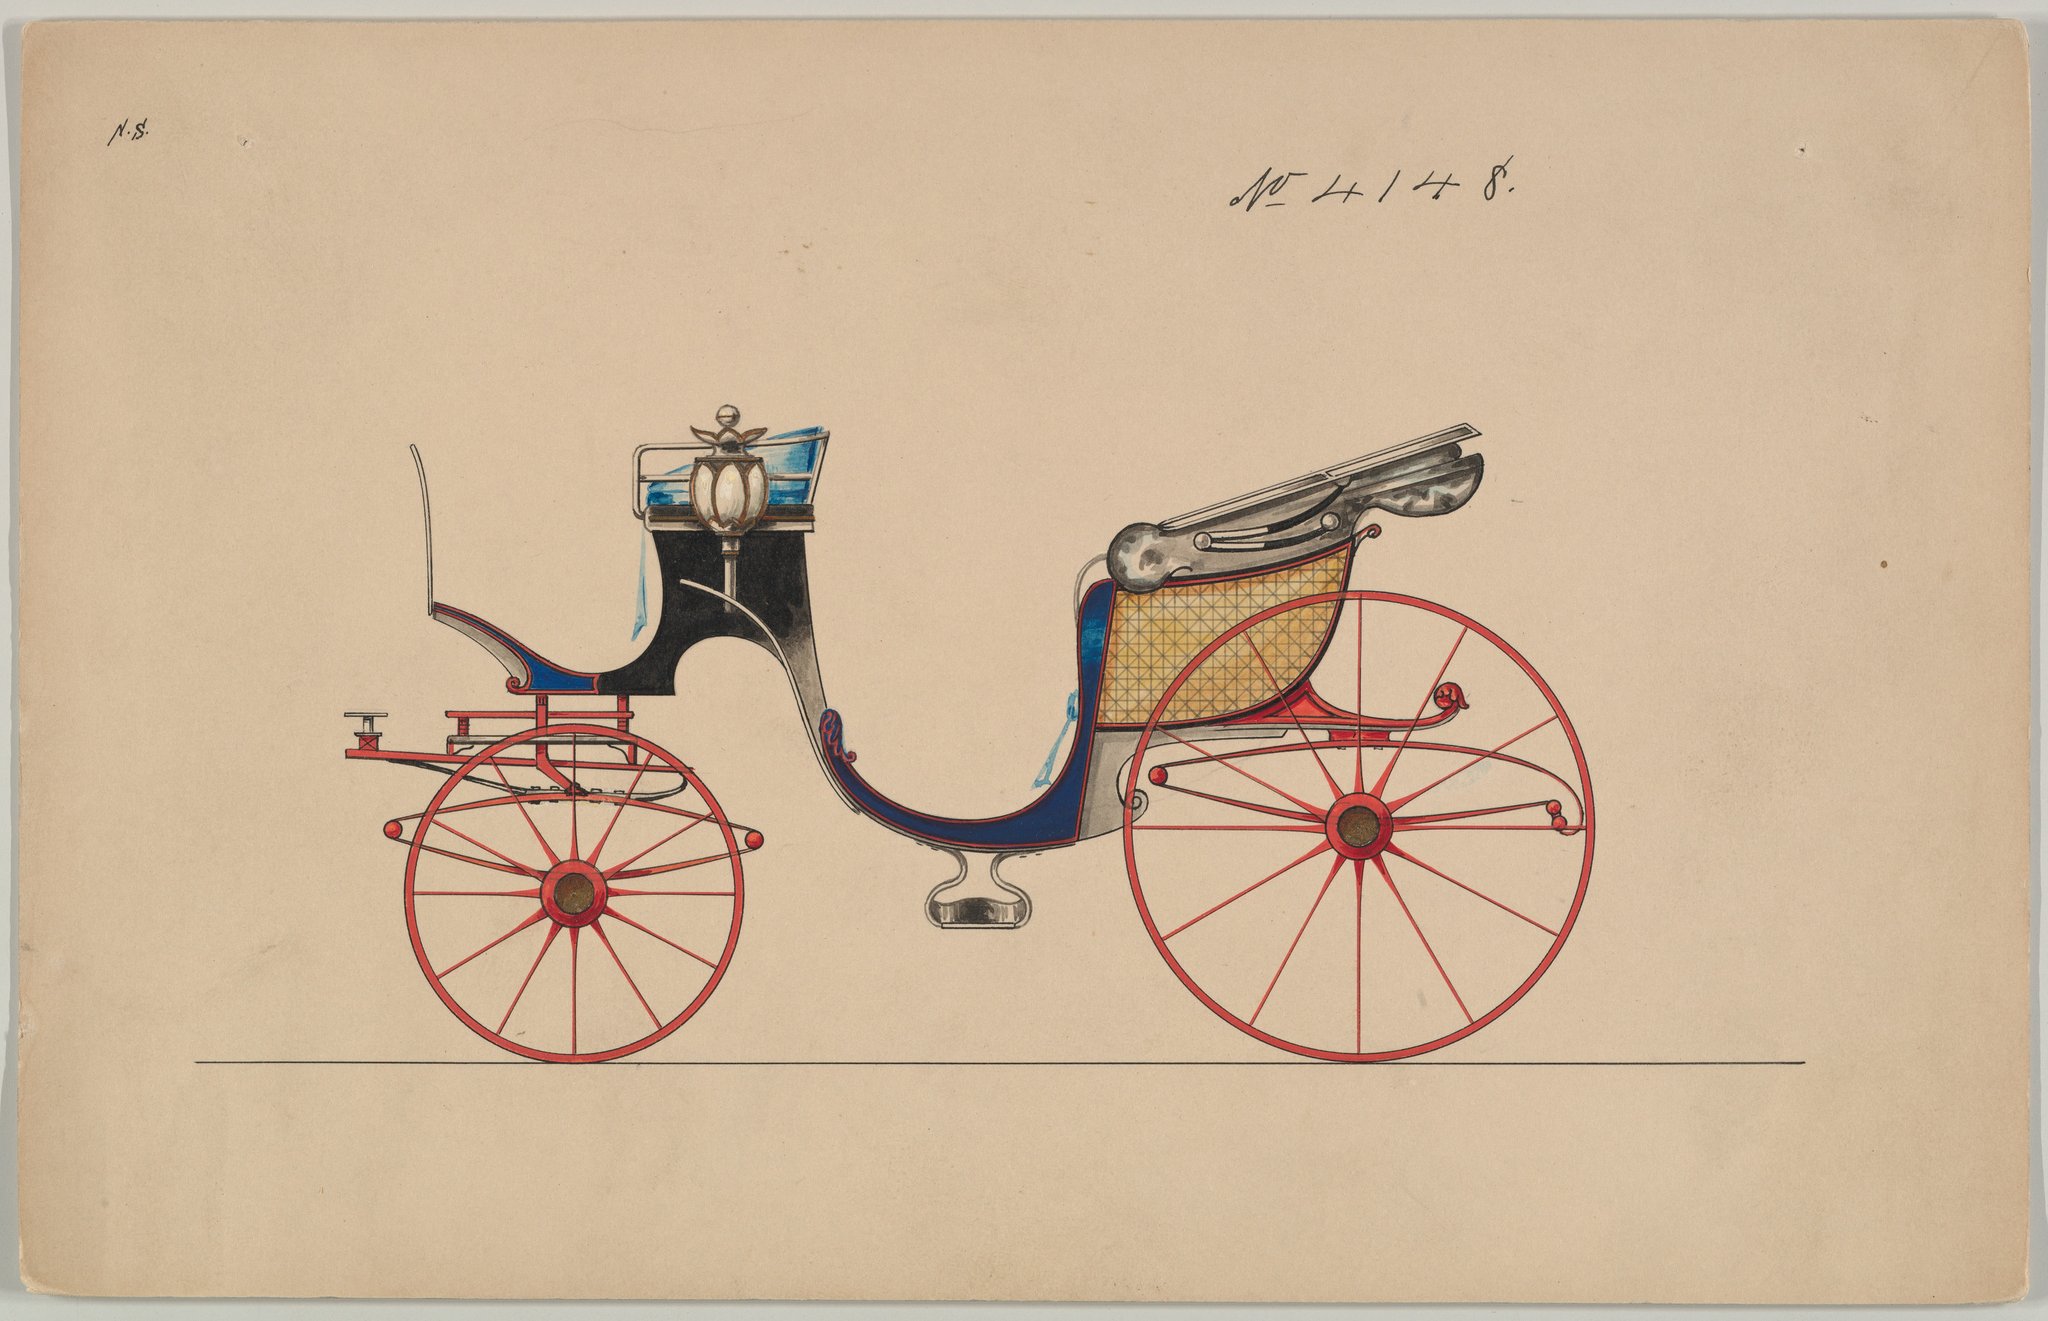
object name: drawing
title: Cabriolet # 4148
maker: brewster & co.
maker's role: manufacturer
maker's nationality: american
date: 1891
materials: gouache, gum arabic, ink, watercolor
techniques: pen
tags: carriages